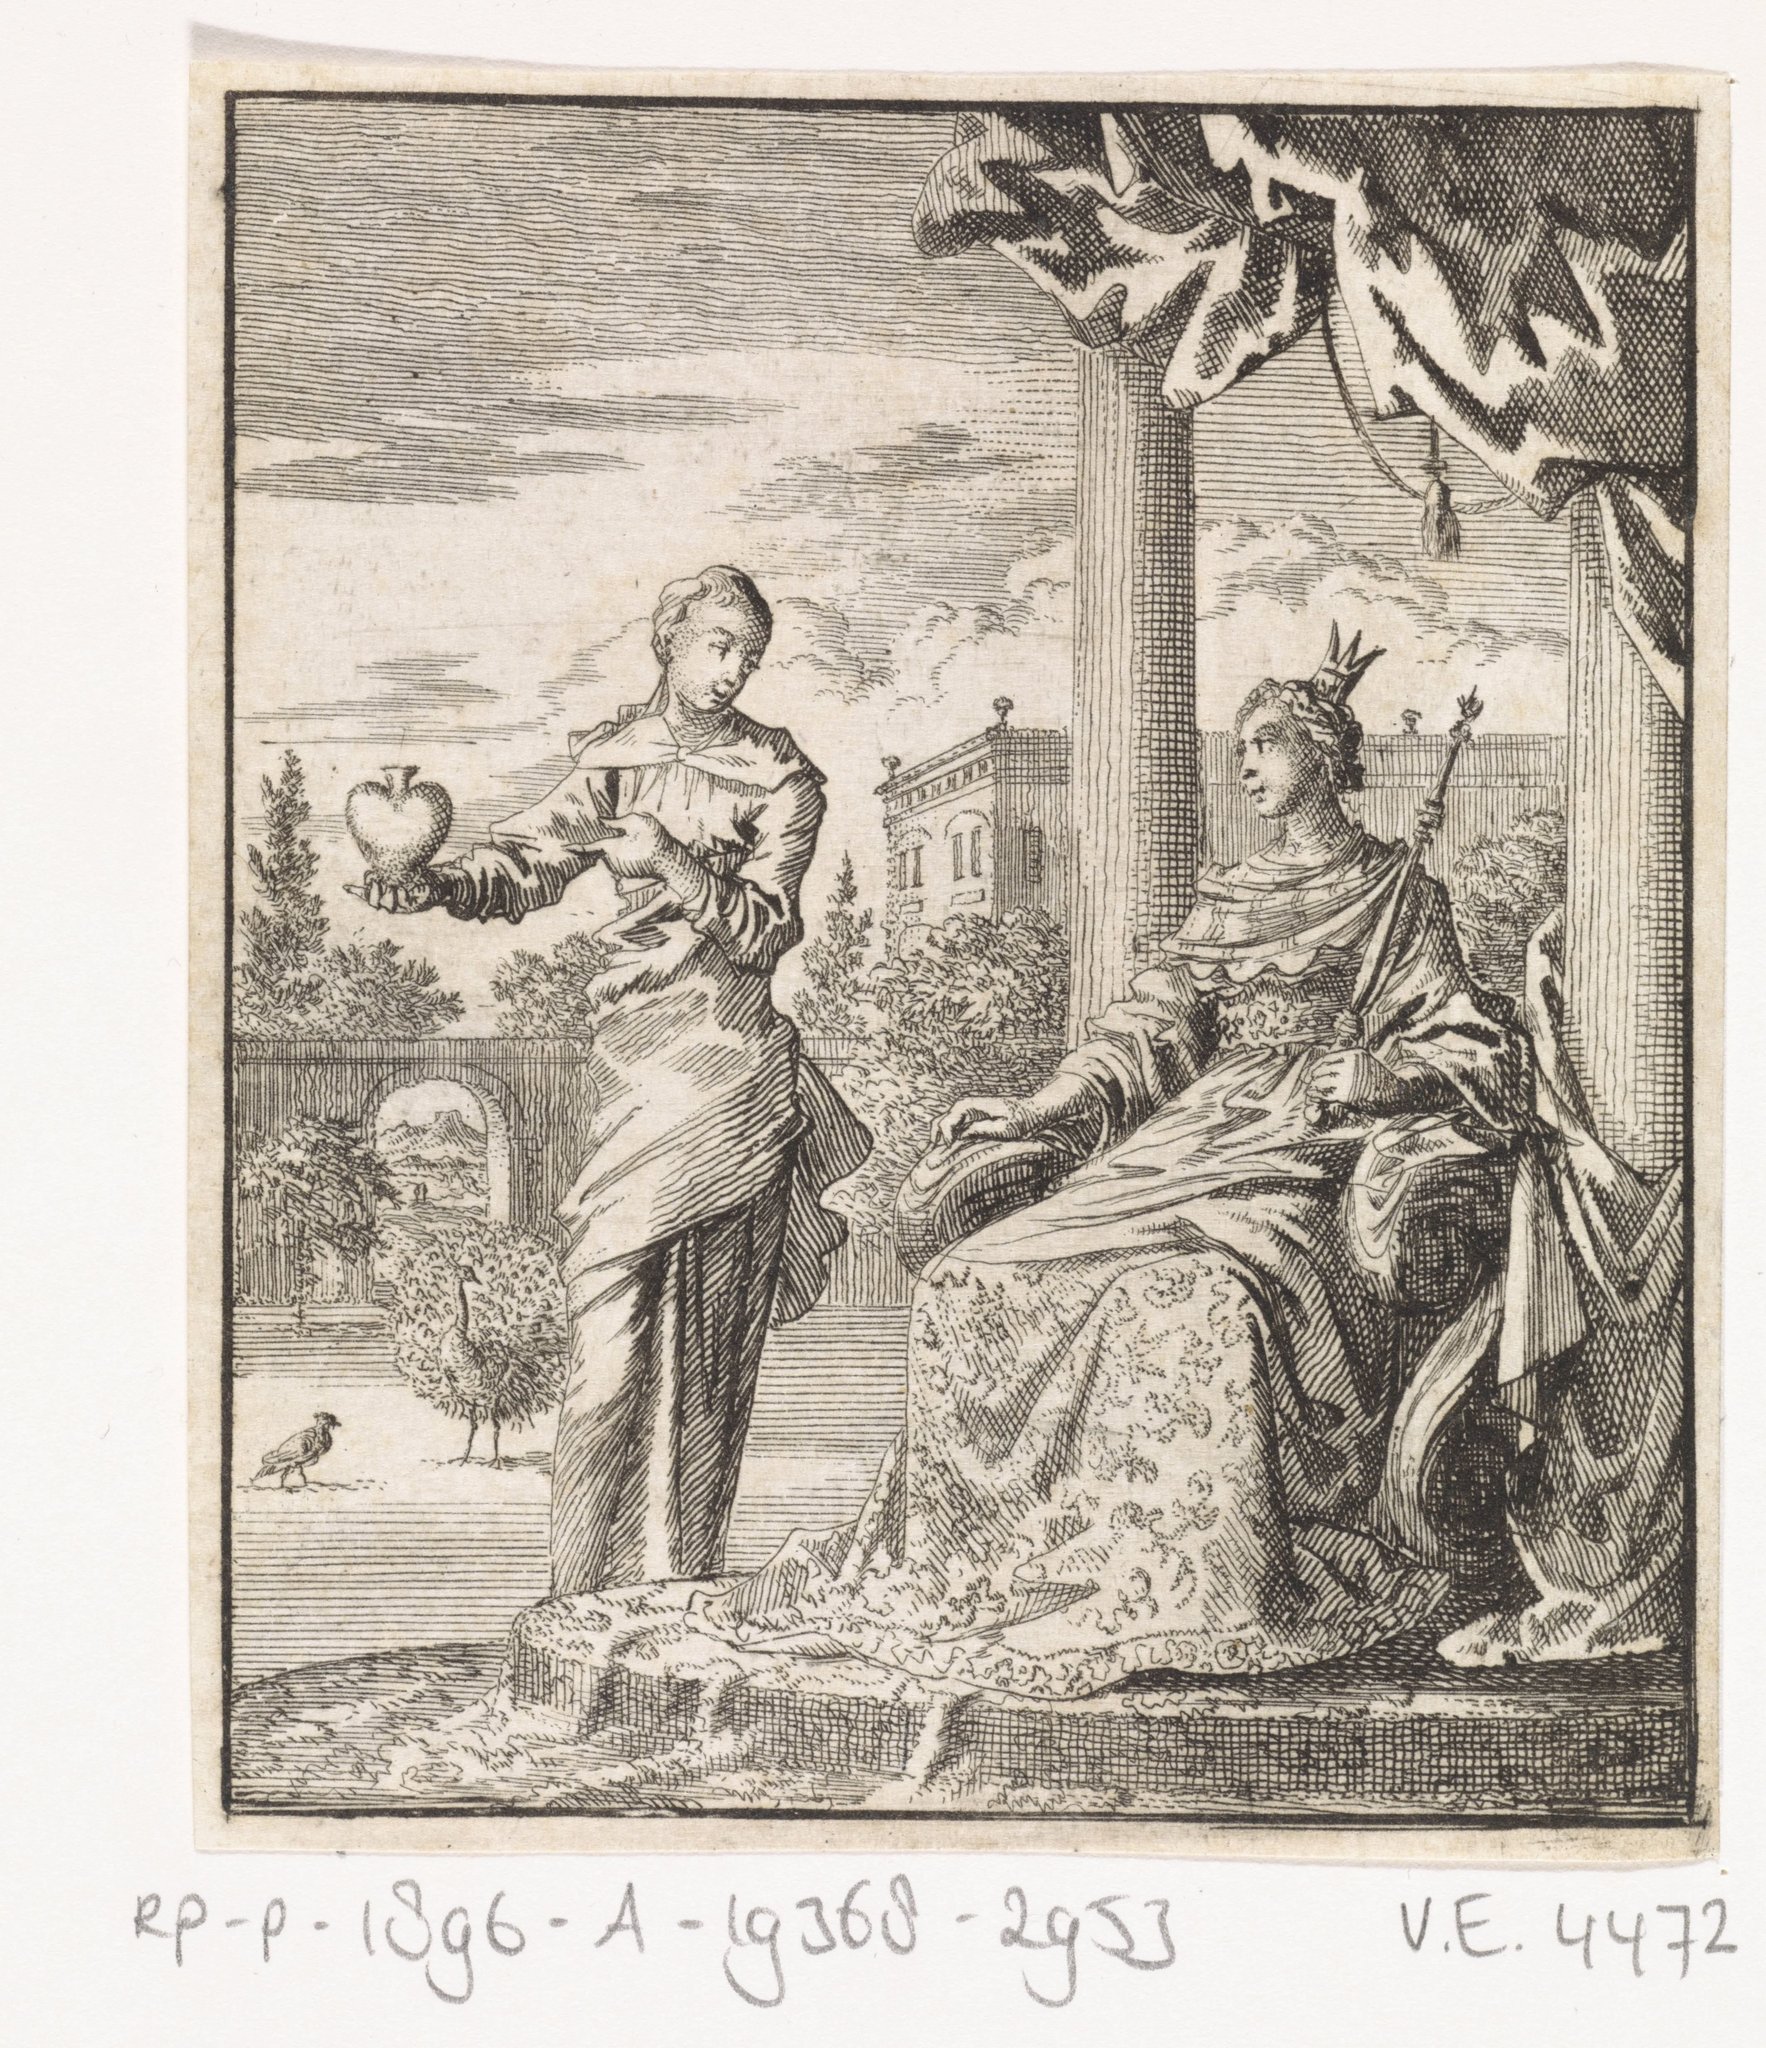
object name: print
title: De Ziel toont haar hart aan de Wereld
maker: jan luyken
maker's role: draughtsman, print maker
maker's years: 1649-1712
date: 1714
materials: paper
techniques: etching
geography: amsterdam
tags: the soul, christ and the human heart, 'frau welt'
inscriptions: collector's mark: Lugt 2228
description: Proefdruk van illustratie uit: Luyken, Jan. Jezus en de Ziel, 3 delen. Amsterdam: Wed. Pieter Arentsz II en Cornelis van der Sys, 1714, dl. III, p. 139.